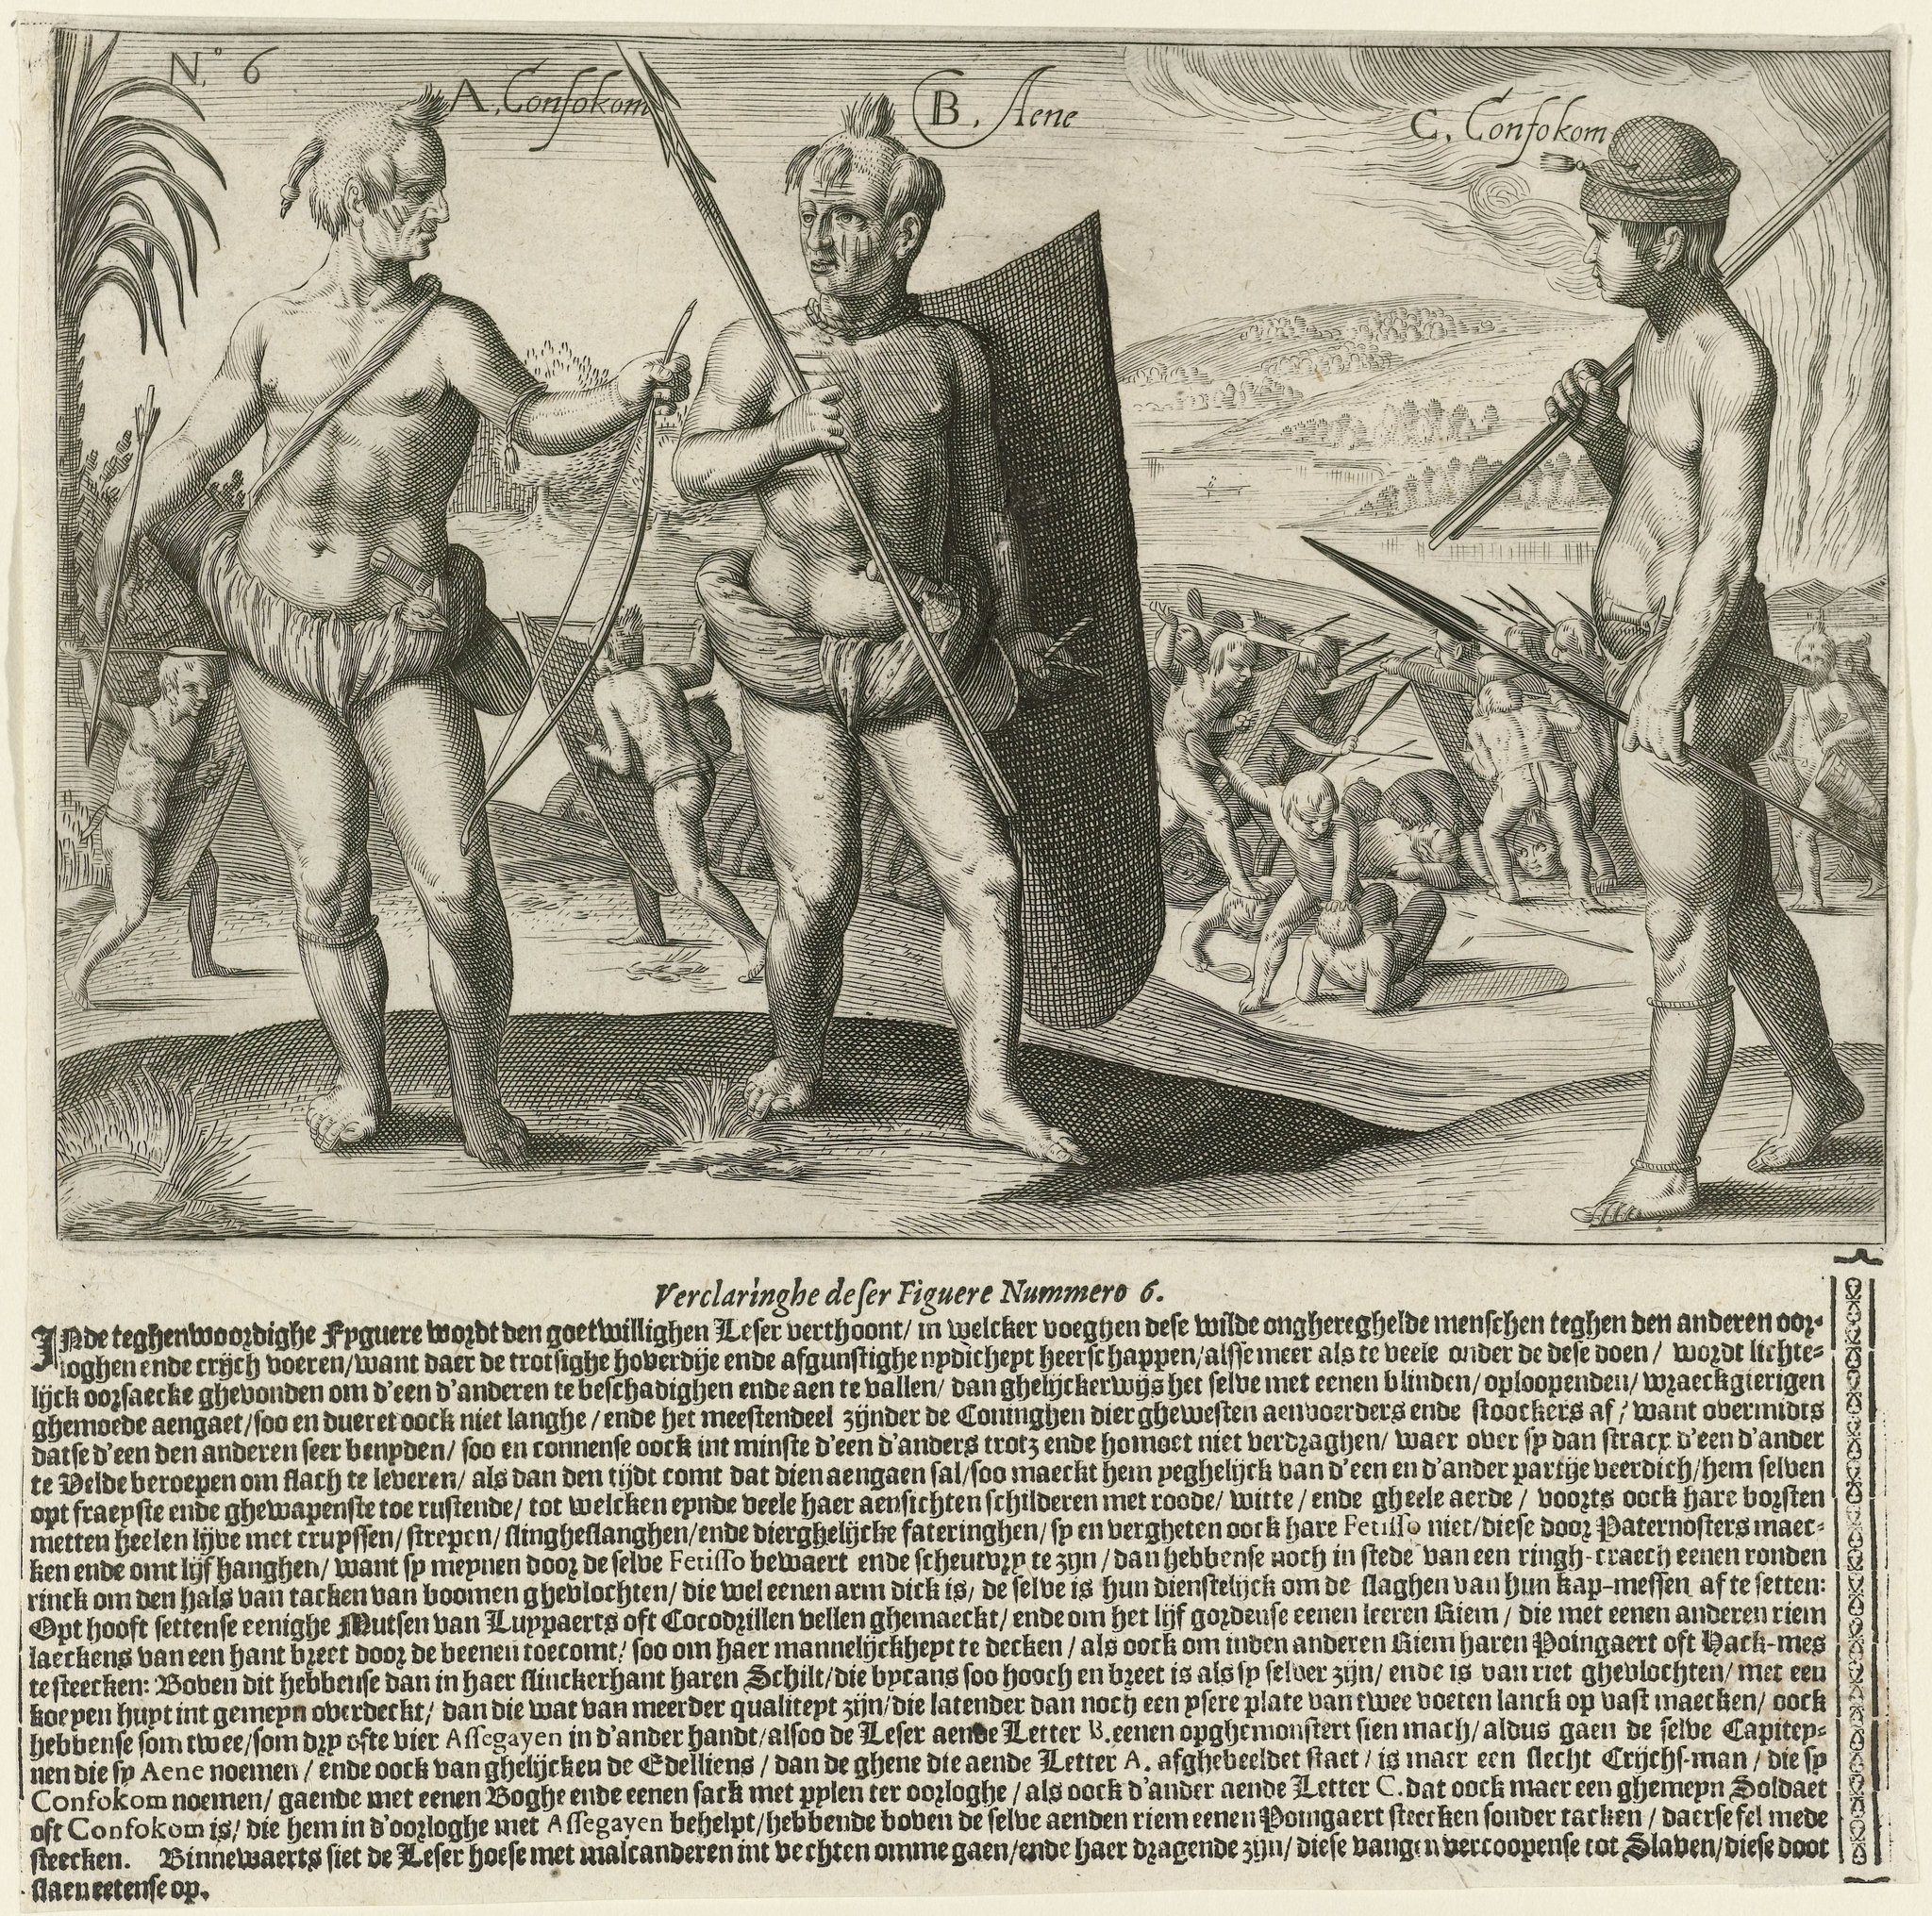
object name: print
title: Beschrijving van de goudkusten van Guinea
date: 1602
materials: paper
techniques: engraving, letterpress printing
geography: frankfurt am main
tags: africans (+ anthropological characteristics emphasized), worship and devotion ~ african tribal religions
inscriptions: collector's mark: Lugt 240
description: Verschillende rituelen van de bevolking van Guinea om hun God 'Fetisso' te eren. Bij D is een wekelijks op dinsdag plaatsvindende vergadering te zien waar ook de kinderen gedoopt worden. A-C laat zien hoe 'Fetisso' door dans, muziek en eten geëerd wordt om bescherming van hem te krijgen.